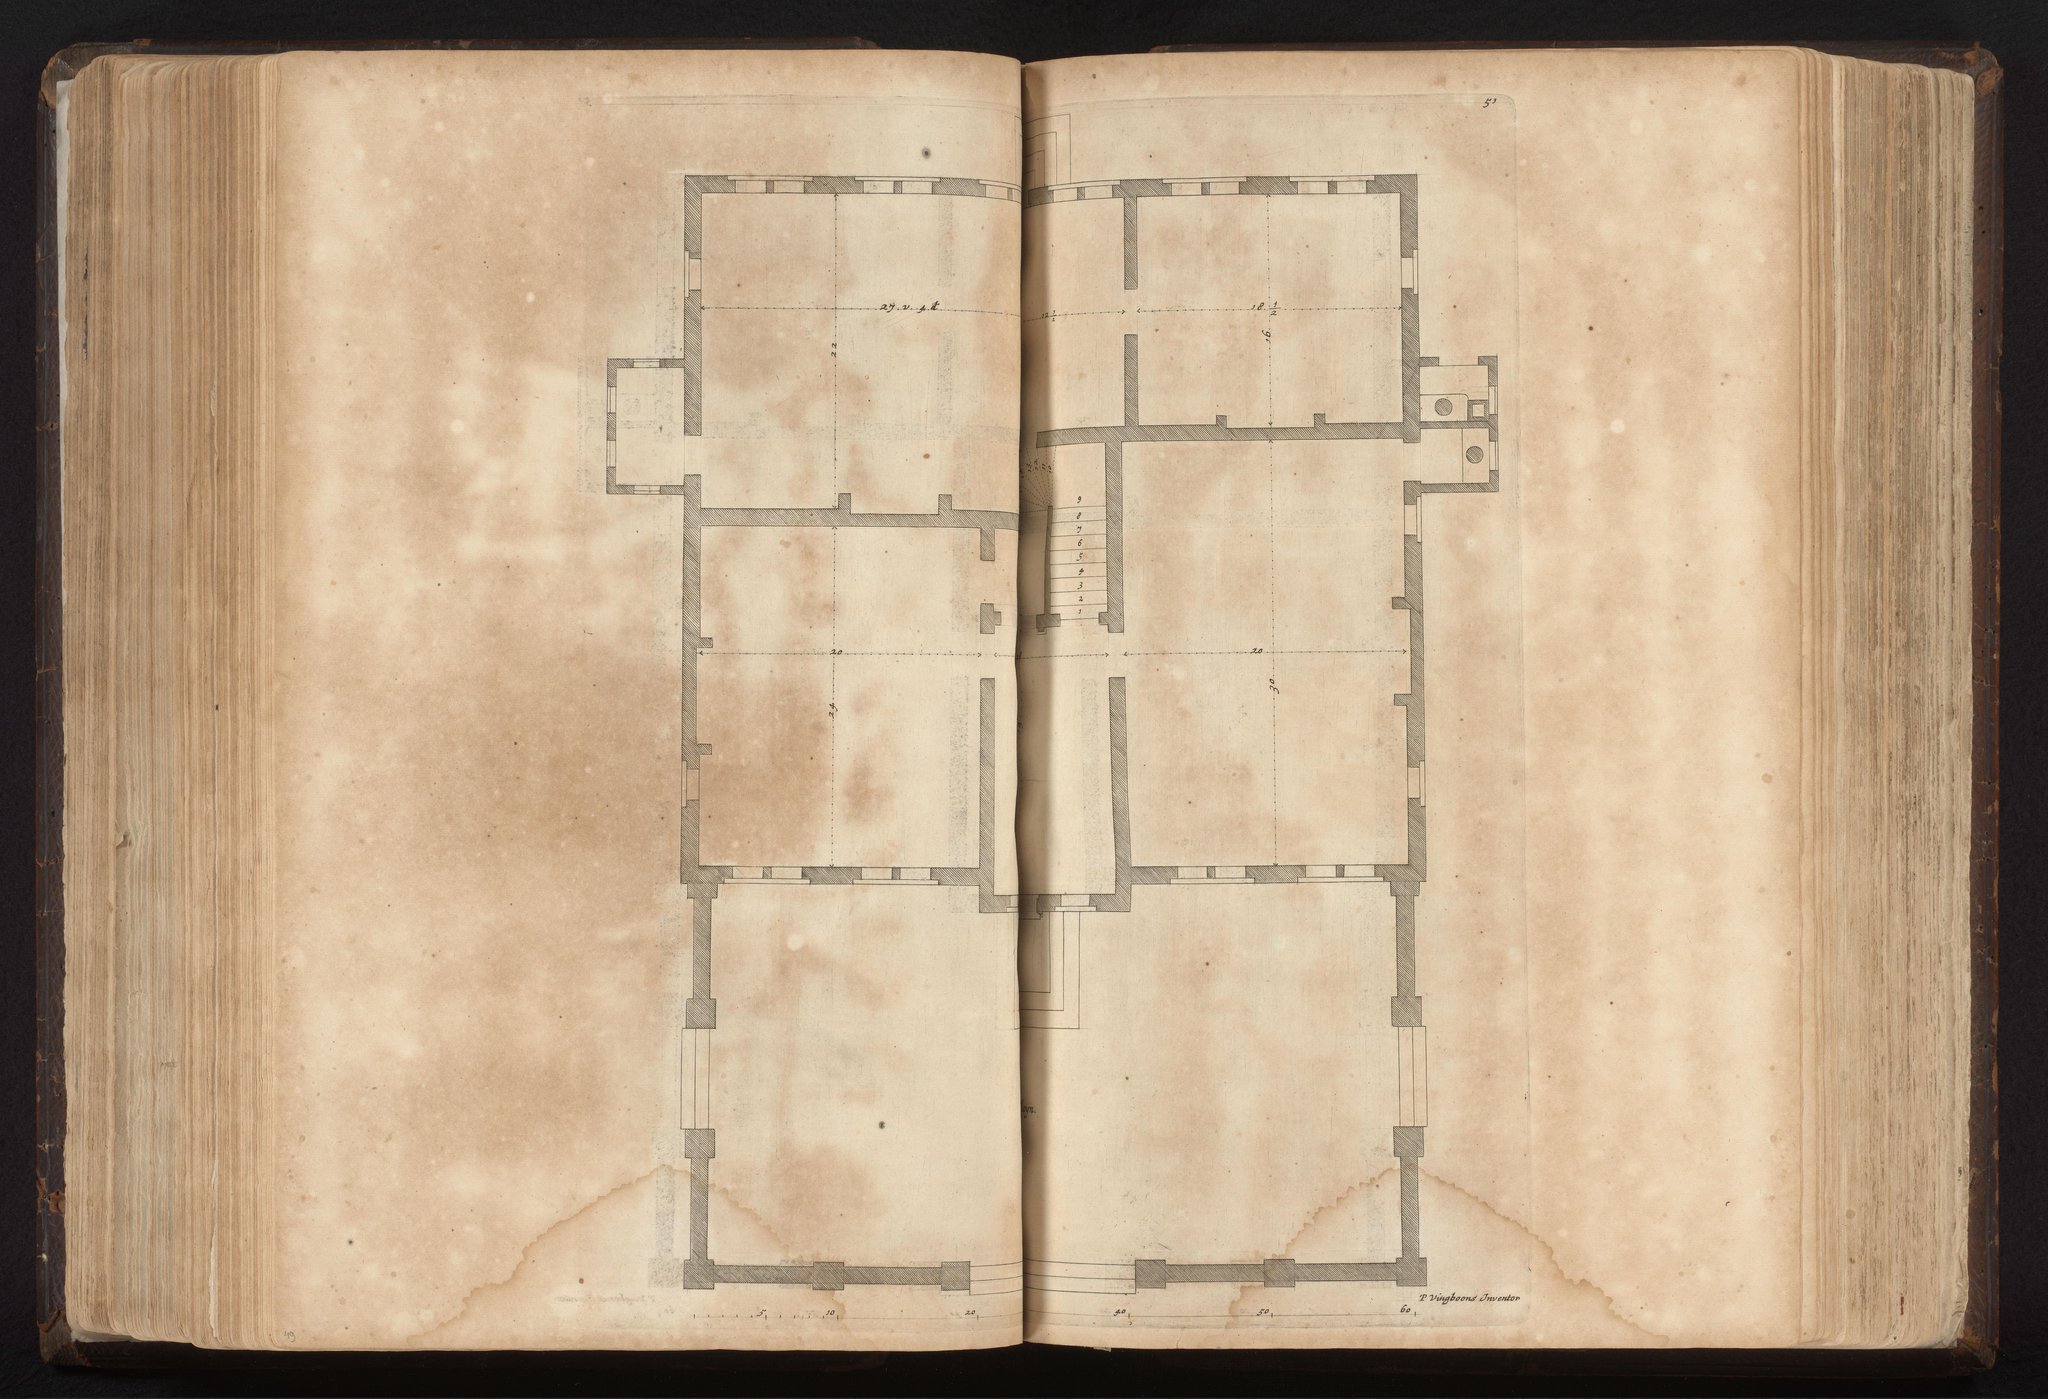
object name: print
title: Plattegrond van het landhuis Pijnenburg te Soest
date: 1648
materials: paper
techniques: engraving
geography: amsterdam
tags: plan ~ architecture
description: Prent uit: Afbeelsels der voornaemste gebouwen uyt alle die Philips Vingboons geordineert heeft. Amsterdam: Philips en Johannes Vinckboons en Johannes Willemszoon Blaeu, 1648.